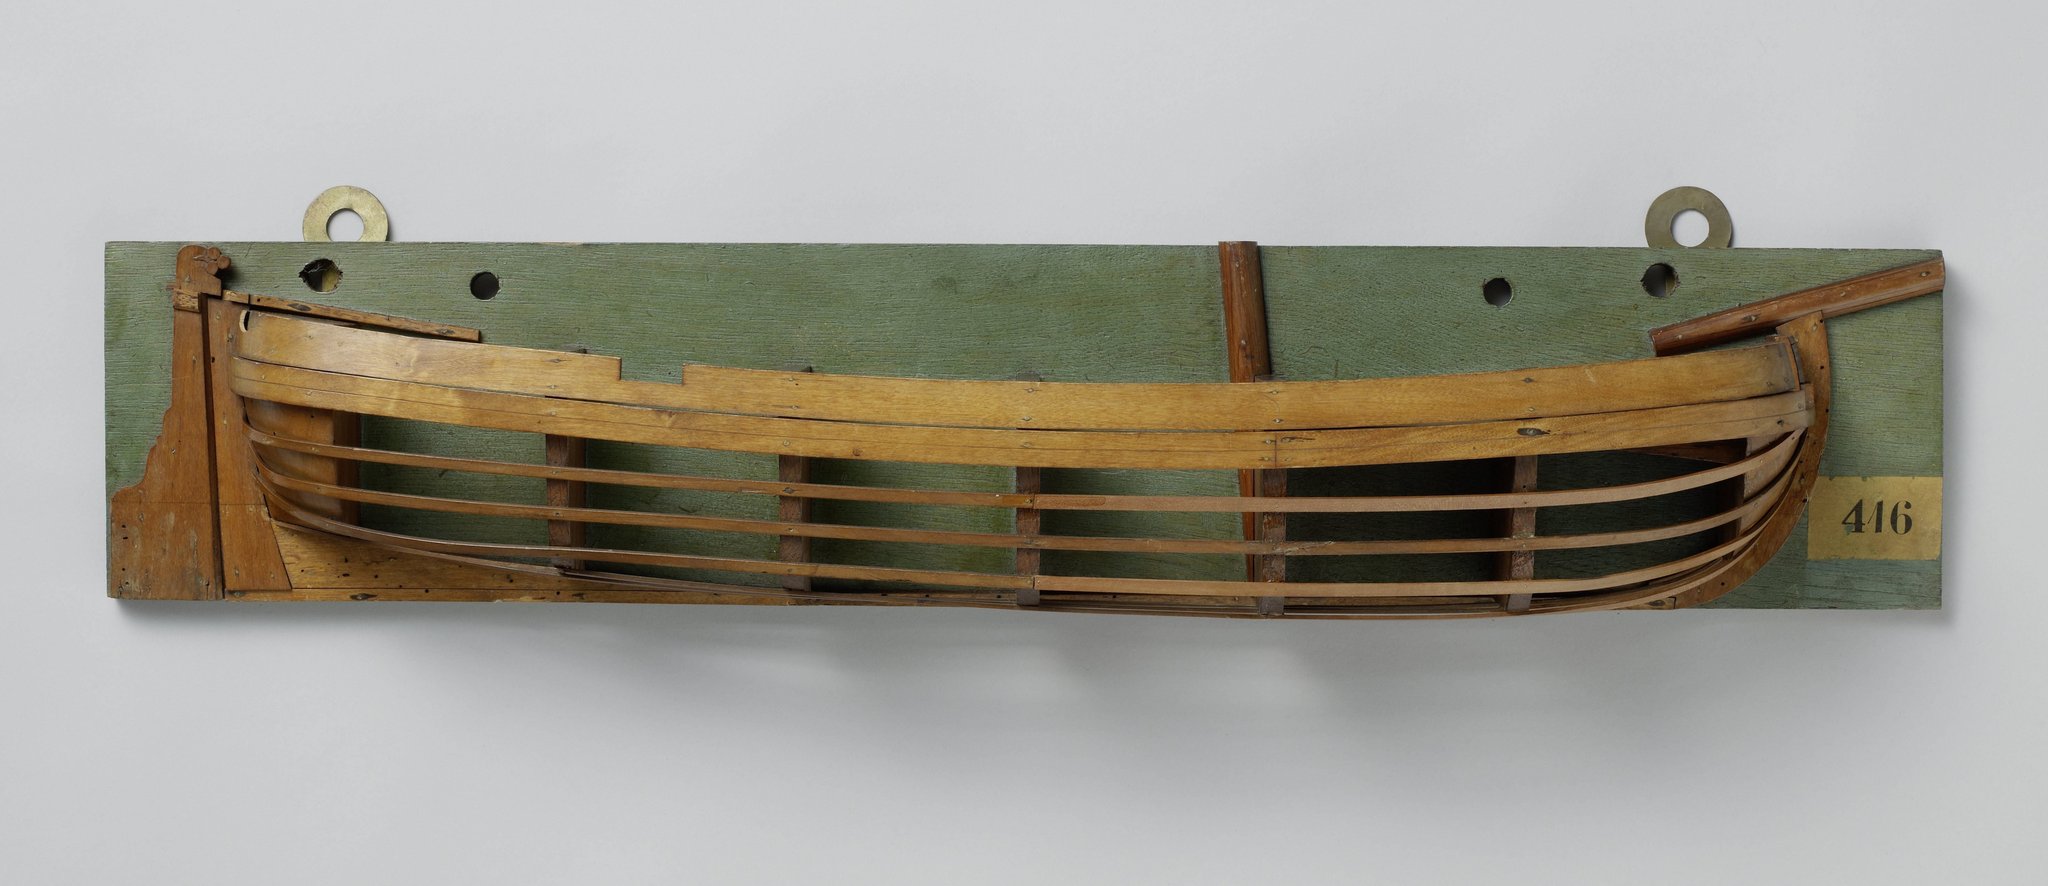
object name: half model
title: Half Model of a Gaff-Rigged Gunboat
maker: Anonymous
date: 1780-1830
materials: paint, wood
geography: netherlands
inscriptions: label, bottom right: ‘416’ former inventory label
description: Mallenmodel (stuurboord) van een eenmaster. De huid boven het barkhout is gesloten; één geschutpoort in de boeg, één op het achterdek. Het voordek is gesloten en heeft een aflopend gedeelte voor het geschut. Rond achterschip, breed roer met helmstok over dek. Platbodem. De zeeg loopt naar voren en achter op, één barkhout. Deze gaffelkanonneerboot had twee stukken voorop en twee in de zijden.